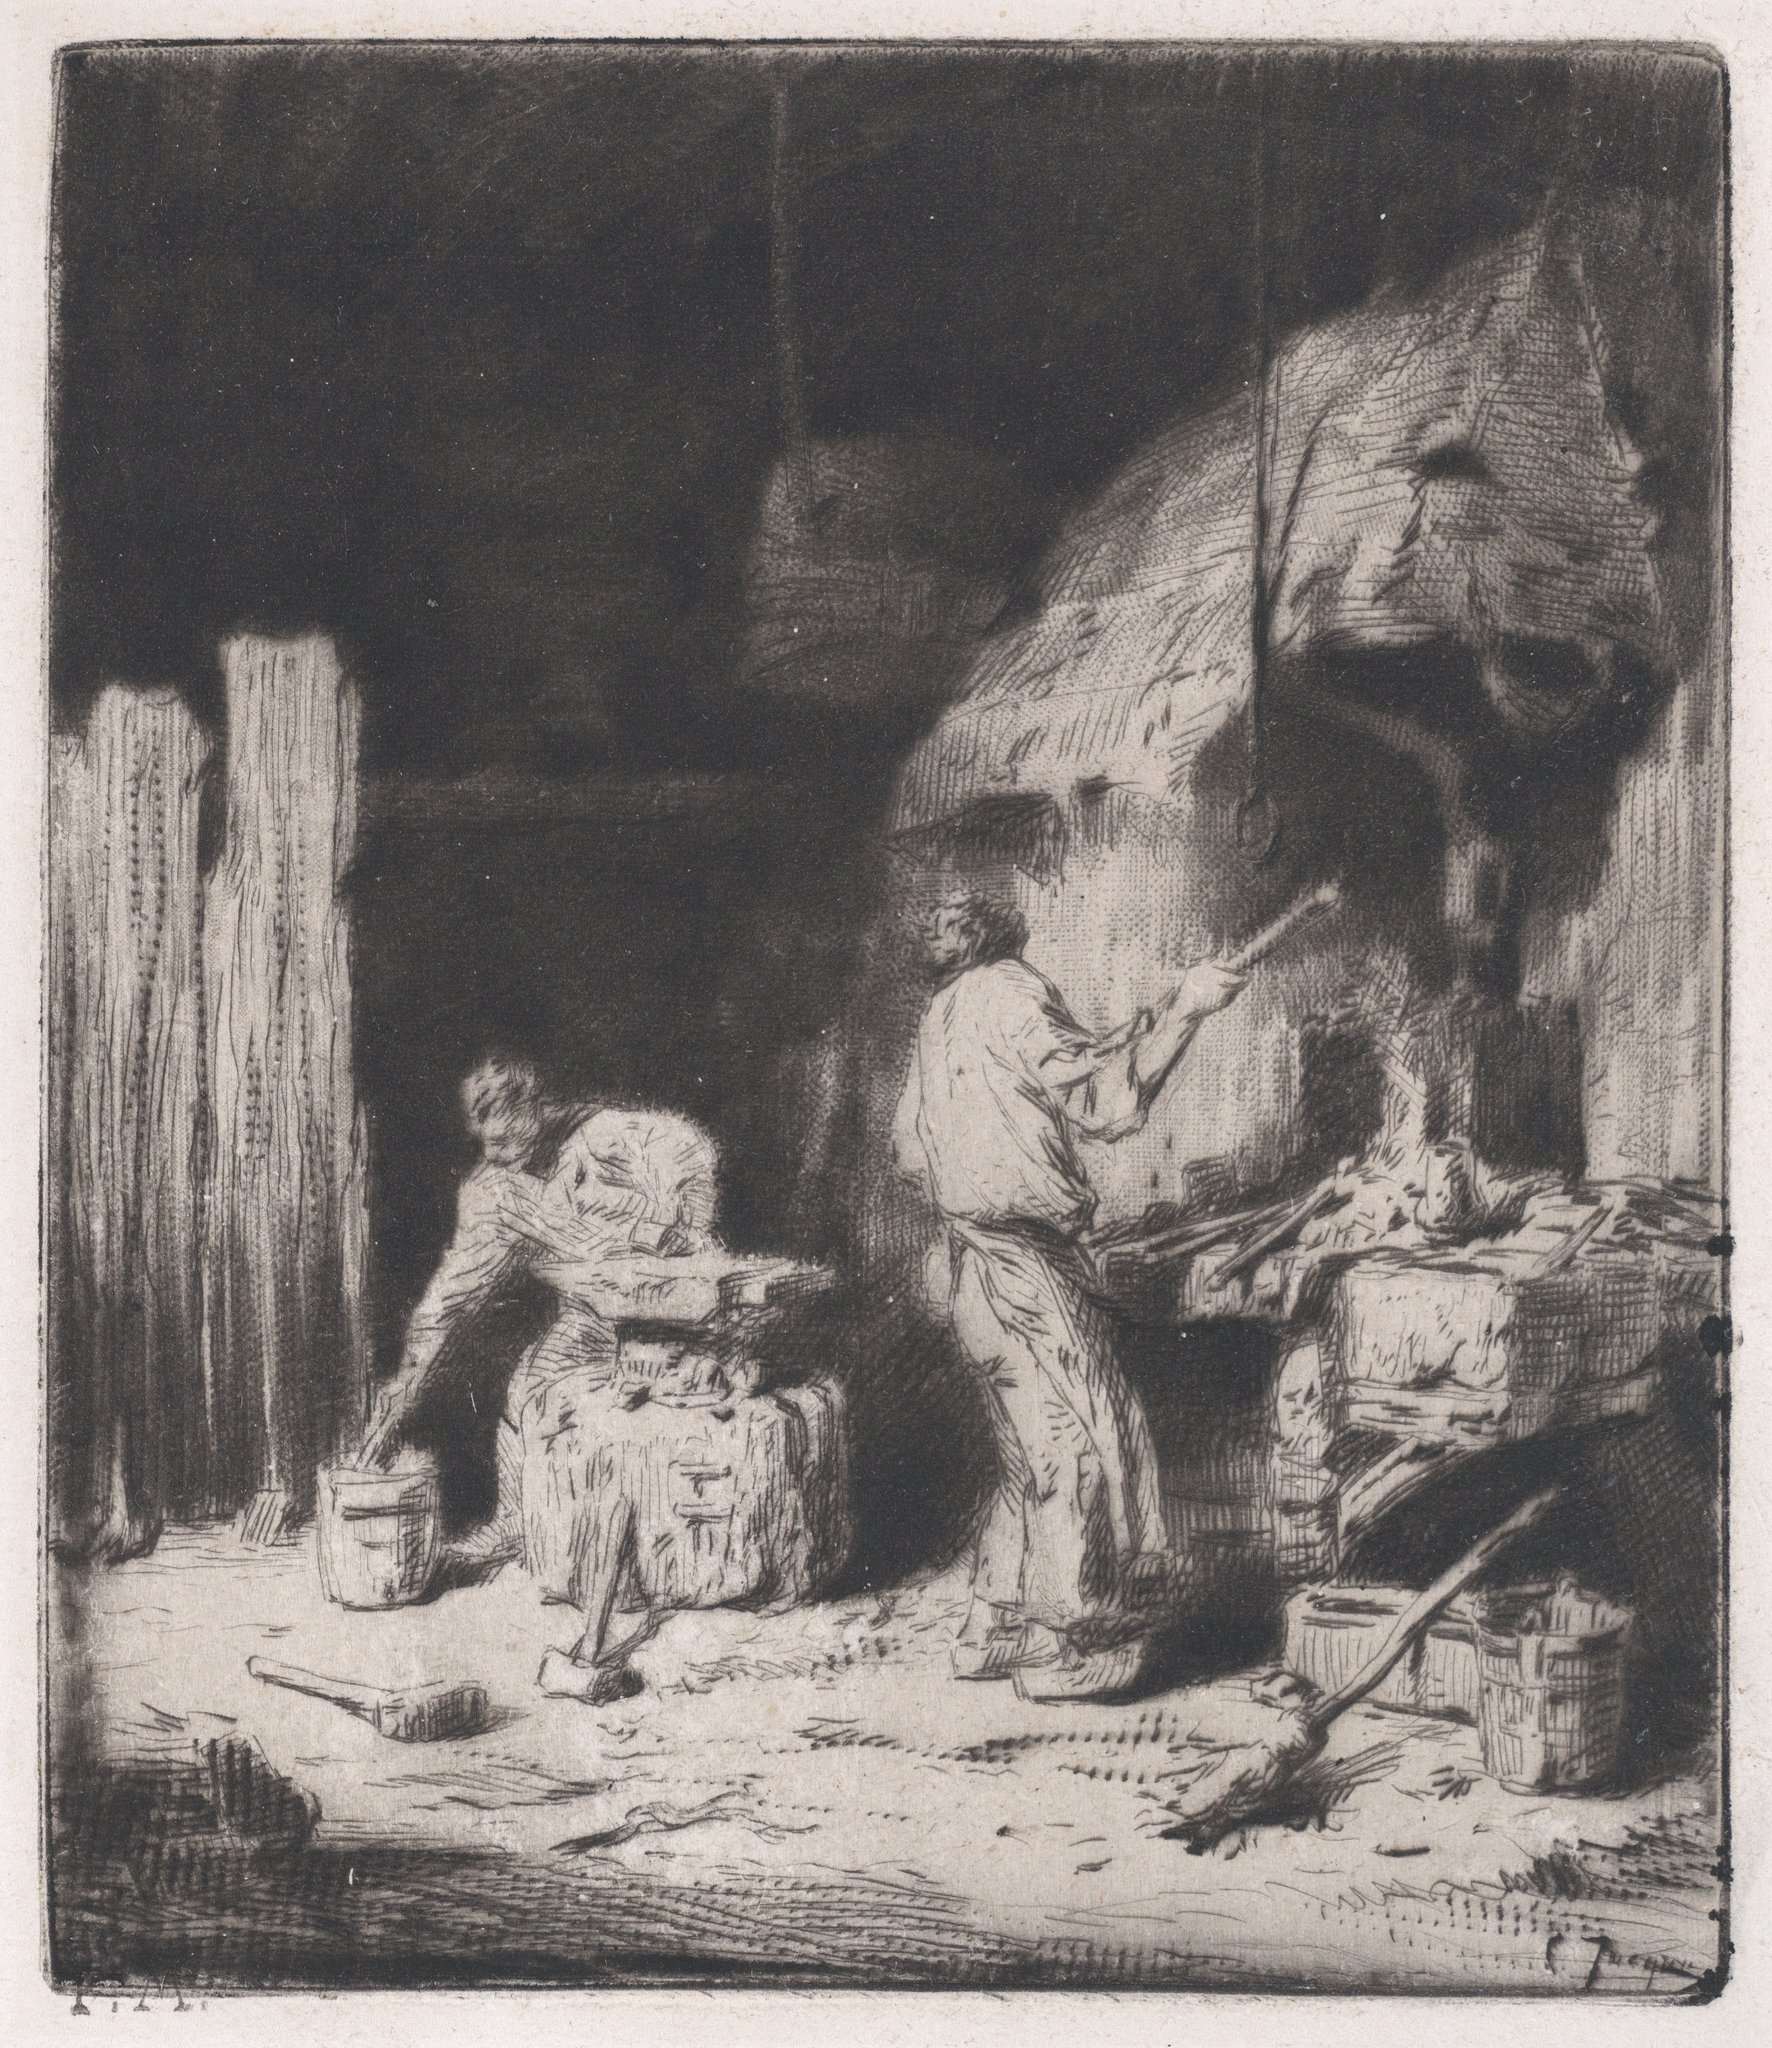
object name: print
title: Forge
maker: charles émile jacque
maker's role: artist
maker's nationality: french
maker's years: 1813-1894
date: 1848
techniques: drypoint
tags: men,working